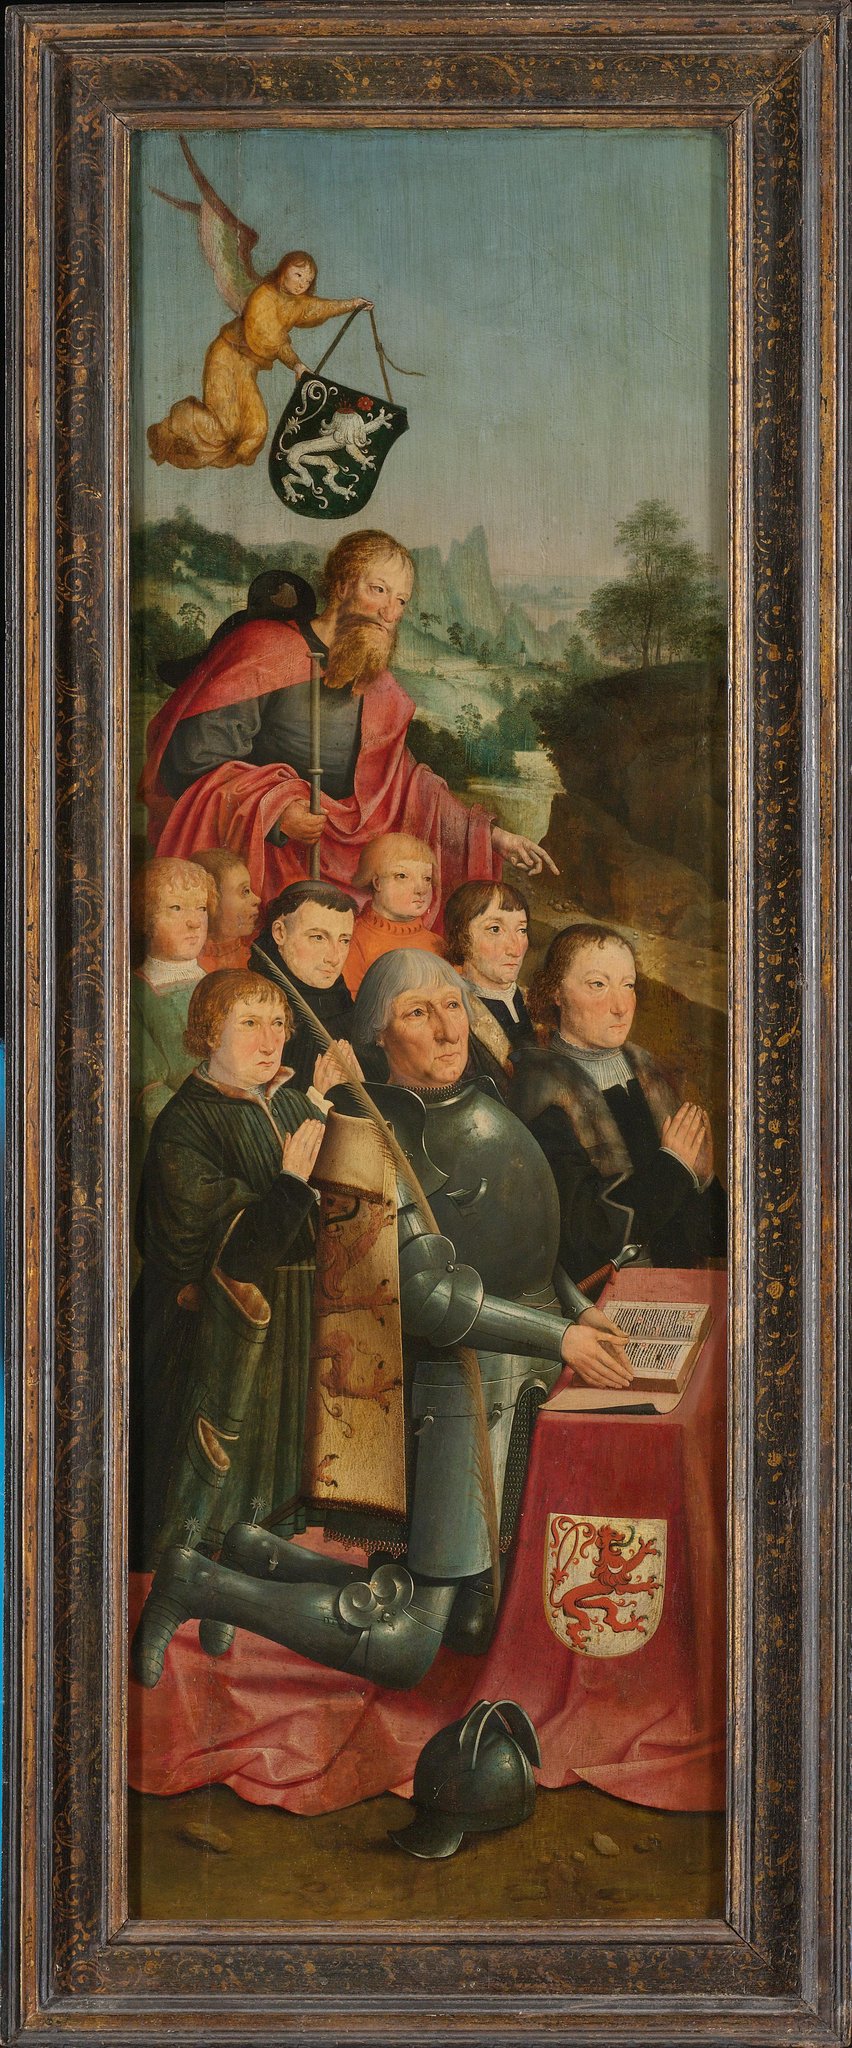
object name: memoriestuk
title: Memorial Panel with Eight Male Portraits, probably Willem Jelysz van Soutelande and Family, with Saint James the Greater and the Van Soutelande Family Crest, inner left wing of an altarpiece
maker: master of alkmaar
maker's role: painter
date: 1515-1520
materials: oil, paint, panel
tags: historical persons, the apostle james the great; possible attributes: book, pilgrim's cloak, hat, shell, staff, and wallet, scroll, sword, armorial bearing, heraldry, historical persons not known by name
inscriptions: coat of arms, upper left, held by an angel: a silver lion, decapitated, trails of blood, on a blue field, a red rose by the raised forepaw, coat of arms, on the reverse: same coat as the one on the front, lower right, coat of arms, lower right, on the end of the prie-dieu: a red lion with two tails, blue tongue and claws, a crescent moon on its chest, on a gold field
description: Zijluik van een memoriestuk met acht portretten van mannen en negen van vrouwen, respectievelijk vergezeld van de heiligen Jacobus Major en Maria Magdalena. Op het linkerpaneel de knielende stichter Willem Jelysz van Soutelande (overl. 1515-16) in de wapenrusting van een ridder van de Broederschap van de Heilige Land. Voor zich een altaar met een opengeslagen boek, achter zich zeven mannen (zijn zoons?) en de heilige Jacobus Major. In de lucht een engel met het wapen van Jacob de Wael van Rozenburg (overl. 1524) een burger van Haarlem. Op het rechterpaneel (SK-A-1188-B) de knielende stichteres Kathrijn van der Graft Willemsdochter (overl. 1490-91), eveneens knielend in aanbidding voor een altaar met opengeslagen boek. Achter haar acht vrouwen (haar dochters?) en de heilige Maria Magdalena. In de lucht een engel met het wapen van Margriet van Waveren. Op de buitenzijden van de panelen staan de wapens van Van Soutelande en het alliantiewapen Van der Graft-Van Soutelande.